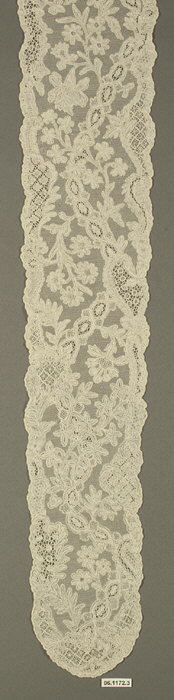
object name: lappet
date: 1701-1800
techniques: lace